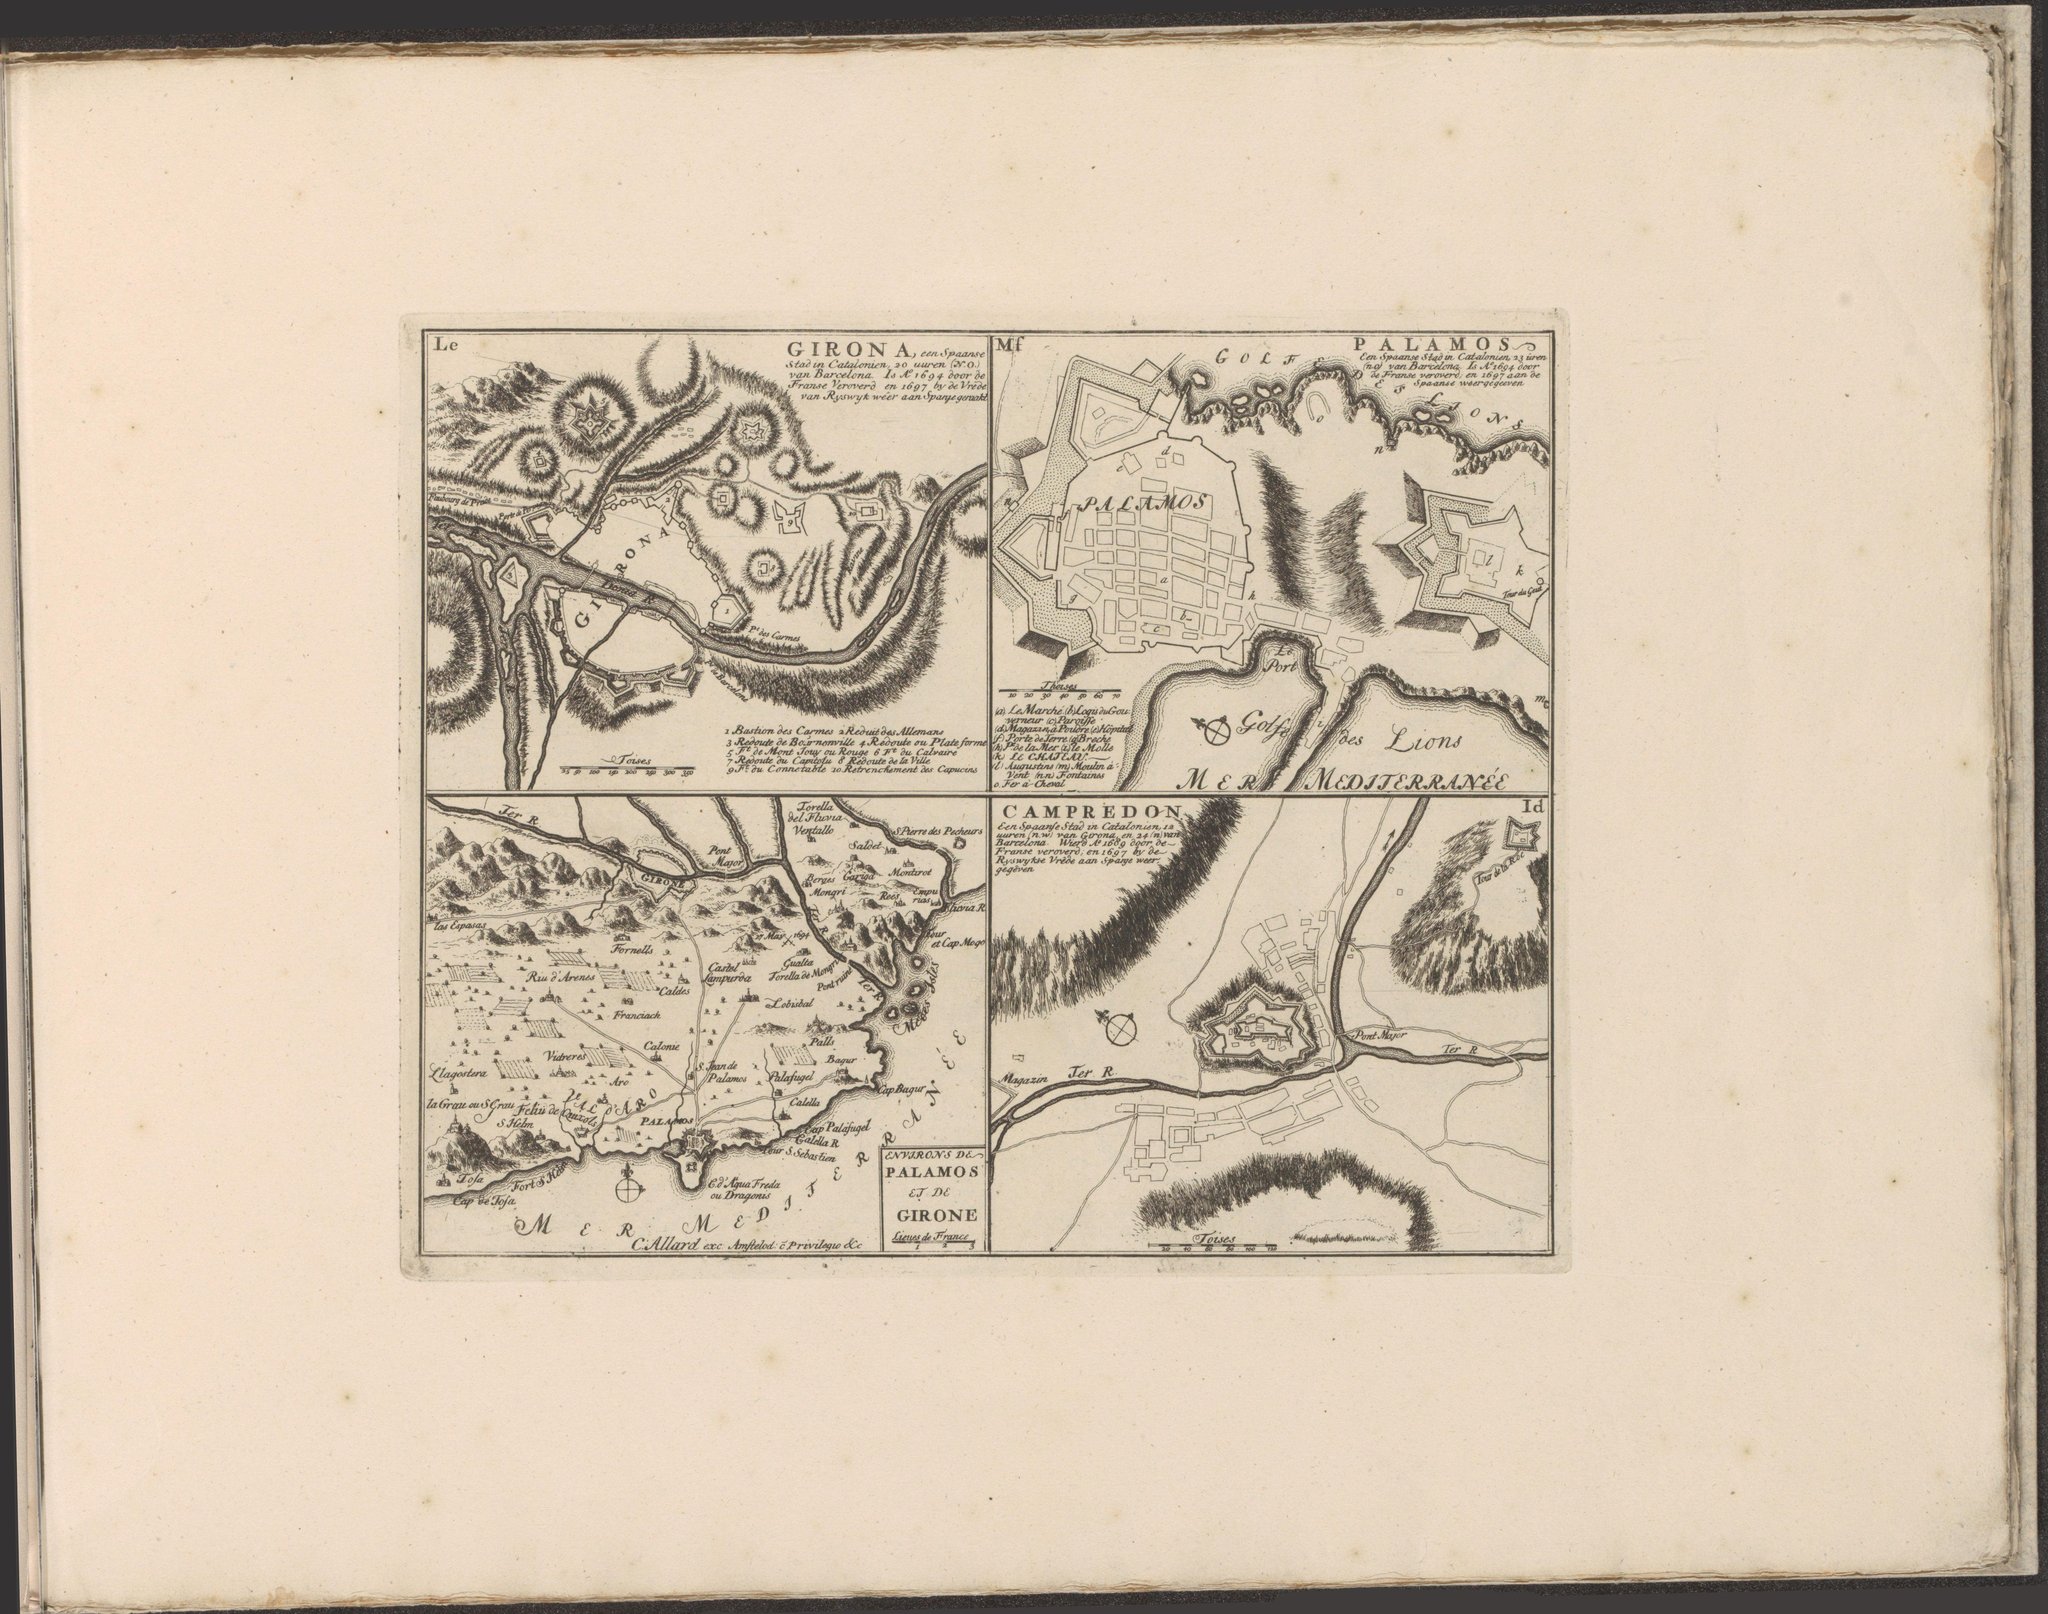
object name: album leaf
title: Girona en andere steden in Catalonië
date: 1701-1733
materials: paper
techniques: etching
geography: leiden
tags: maps of cities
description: Voorstelling met vier kaarten van steden in Catalonië ten tijde of net voor de Spaanse Successieoorlog. Met teksten in het Nederlands en Frans. De prent maakt deel uit van een album.